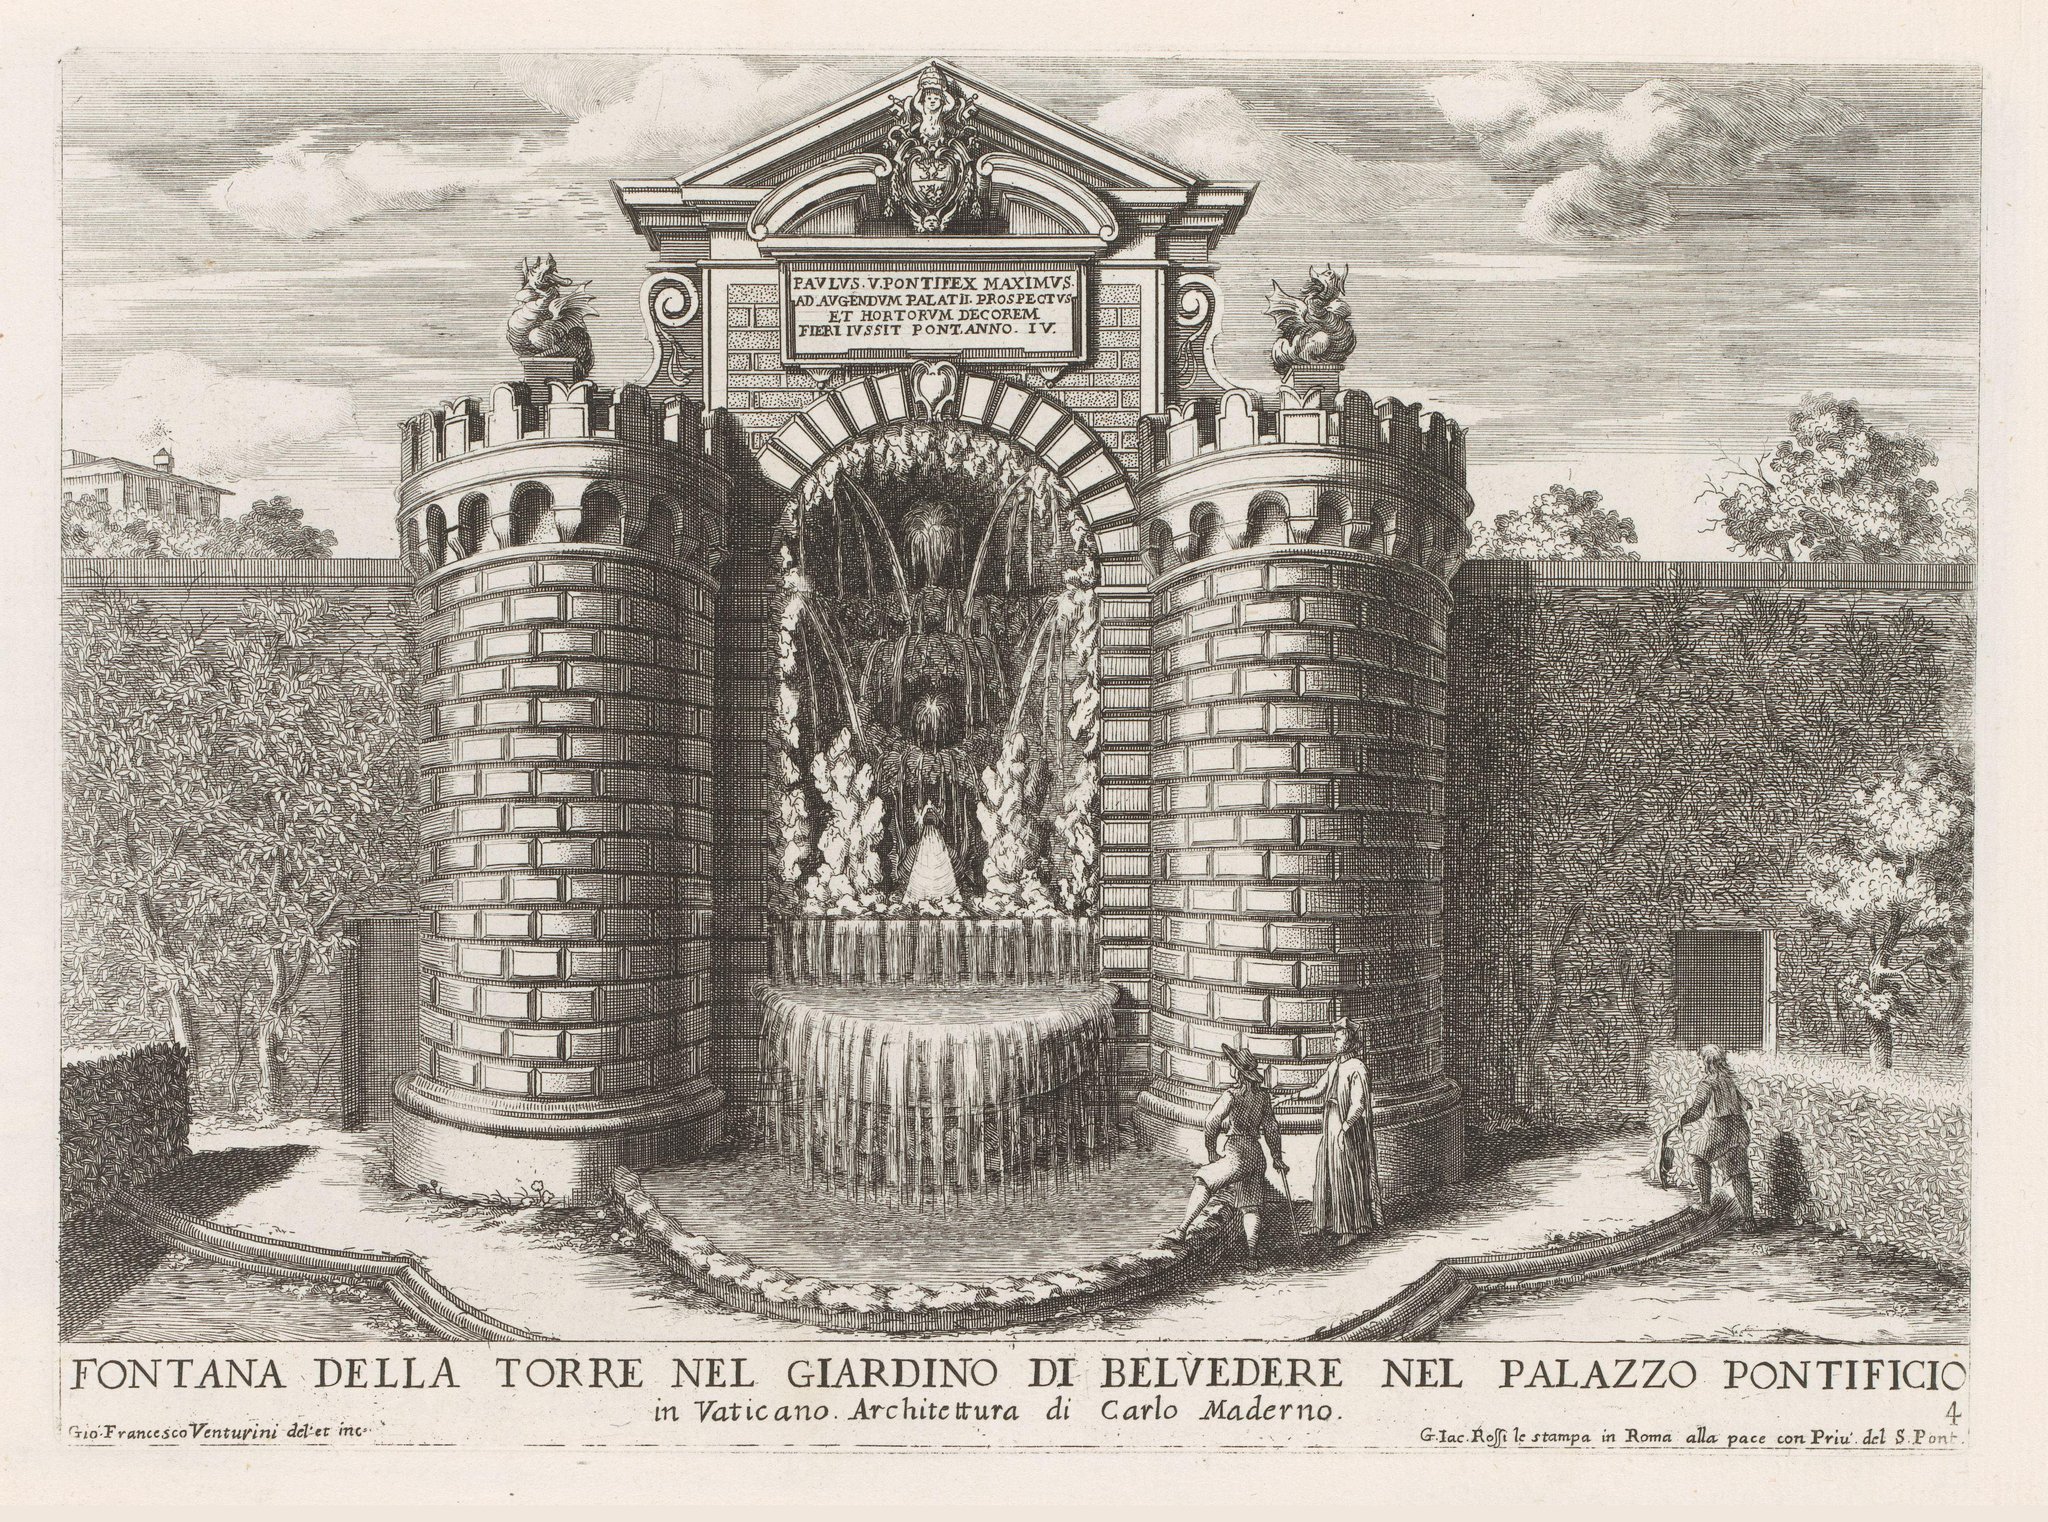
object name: print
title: Fonteinen in de paleizen en tuinen van Rome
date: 1653-1691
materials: paper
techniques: etching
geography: vatican city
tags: ornamental fountain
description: Genummerd rechtsonder: 4. De prent maakt deel uit van een album.